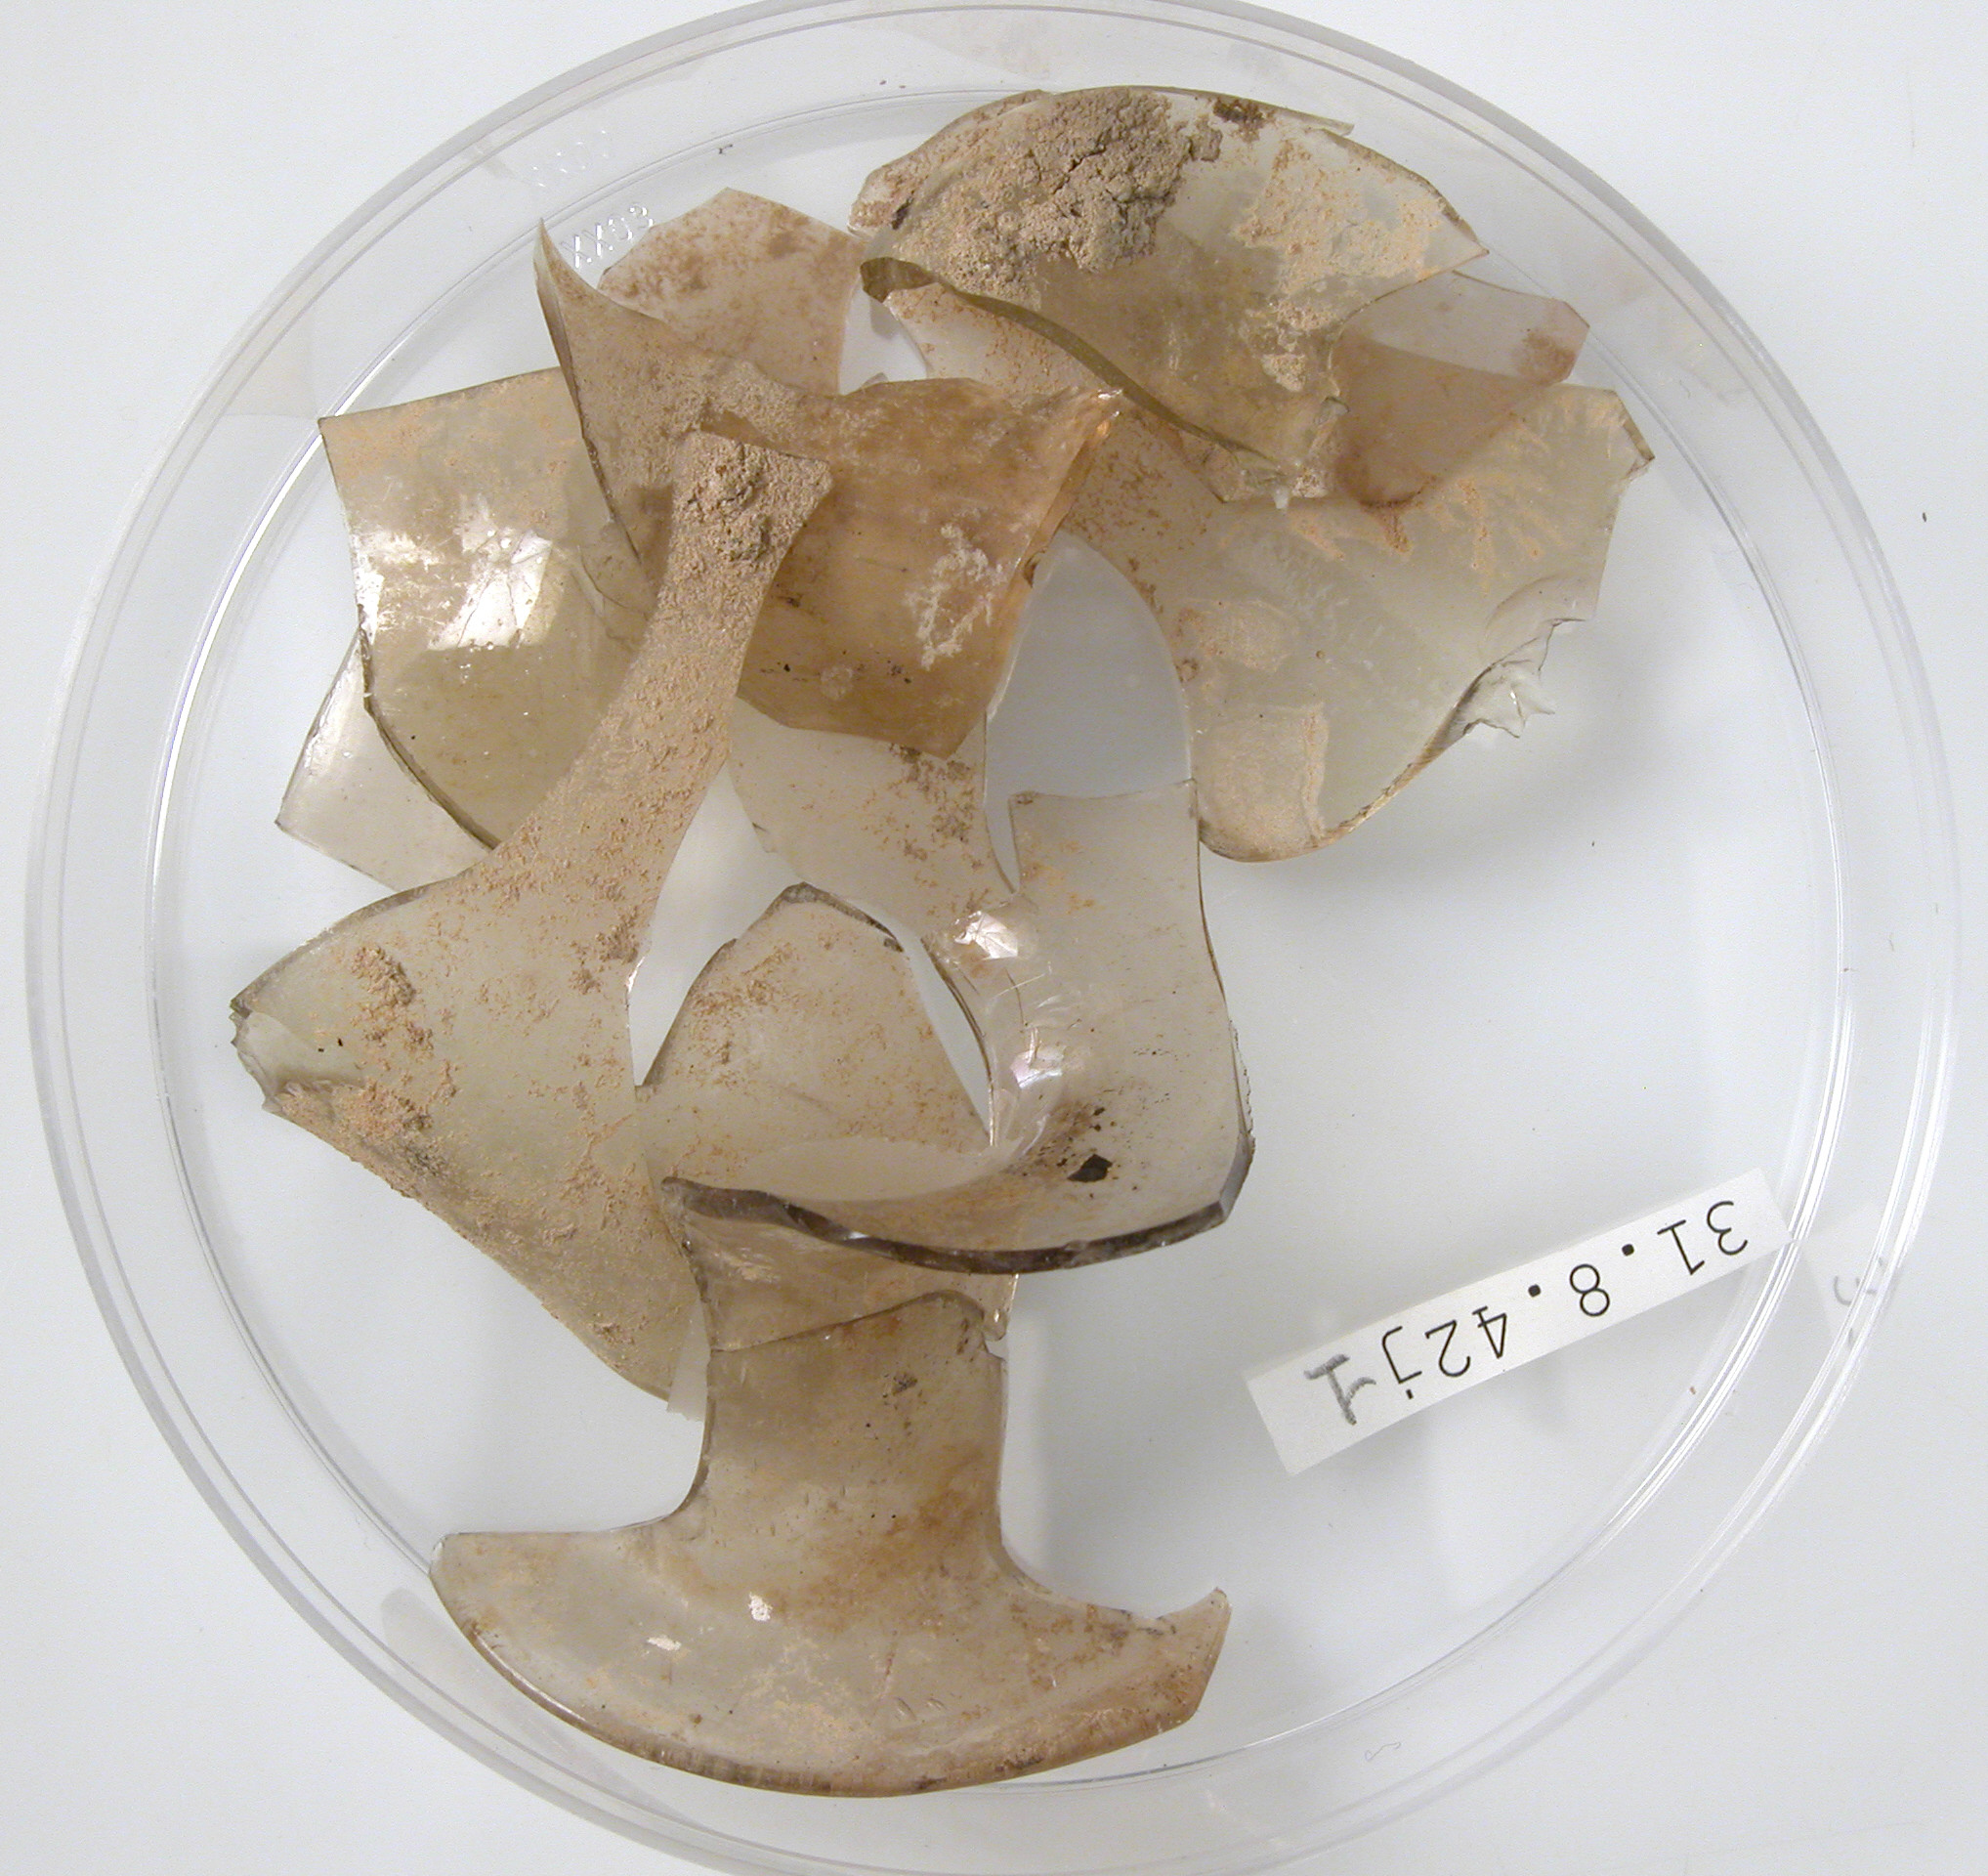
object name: fragment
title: Glass Fragments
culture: coptic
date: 301-400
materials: glass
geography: egypt